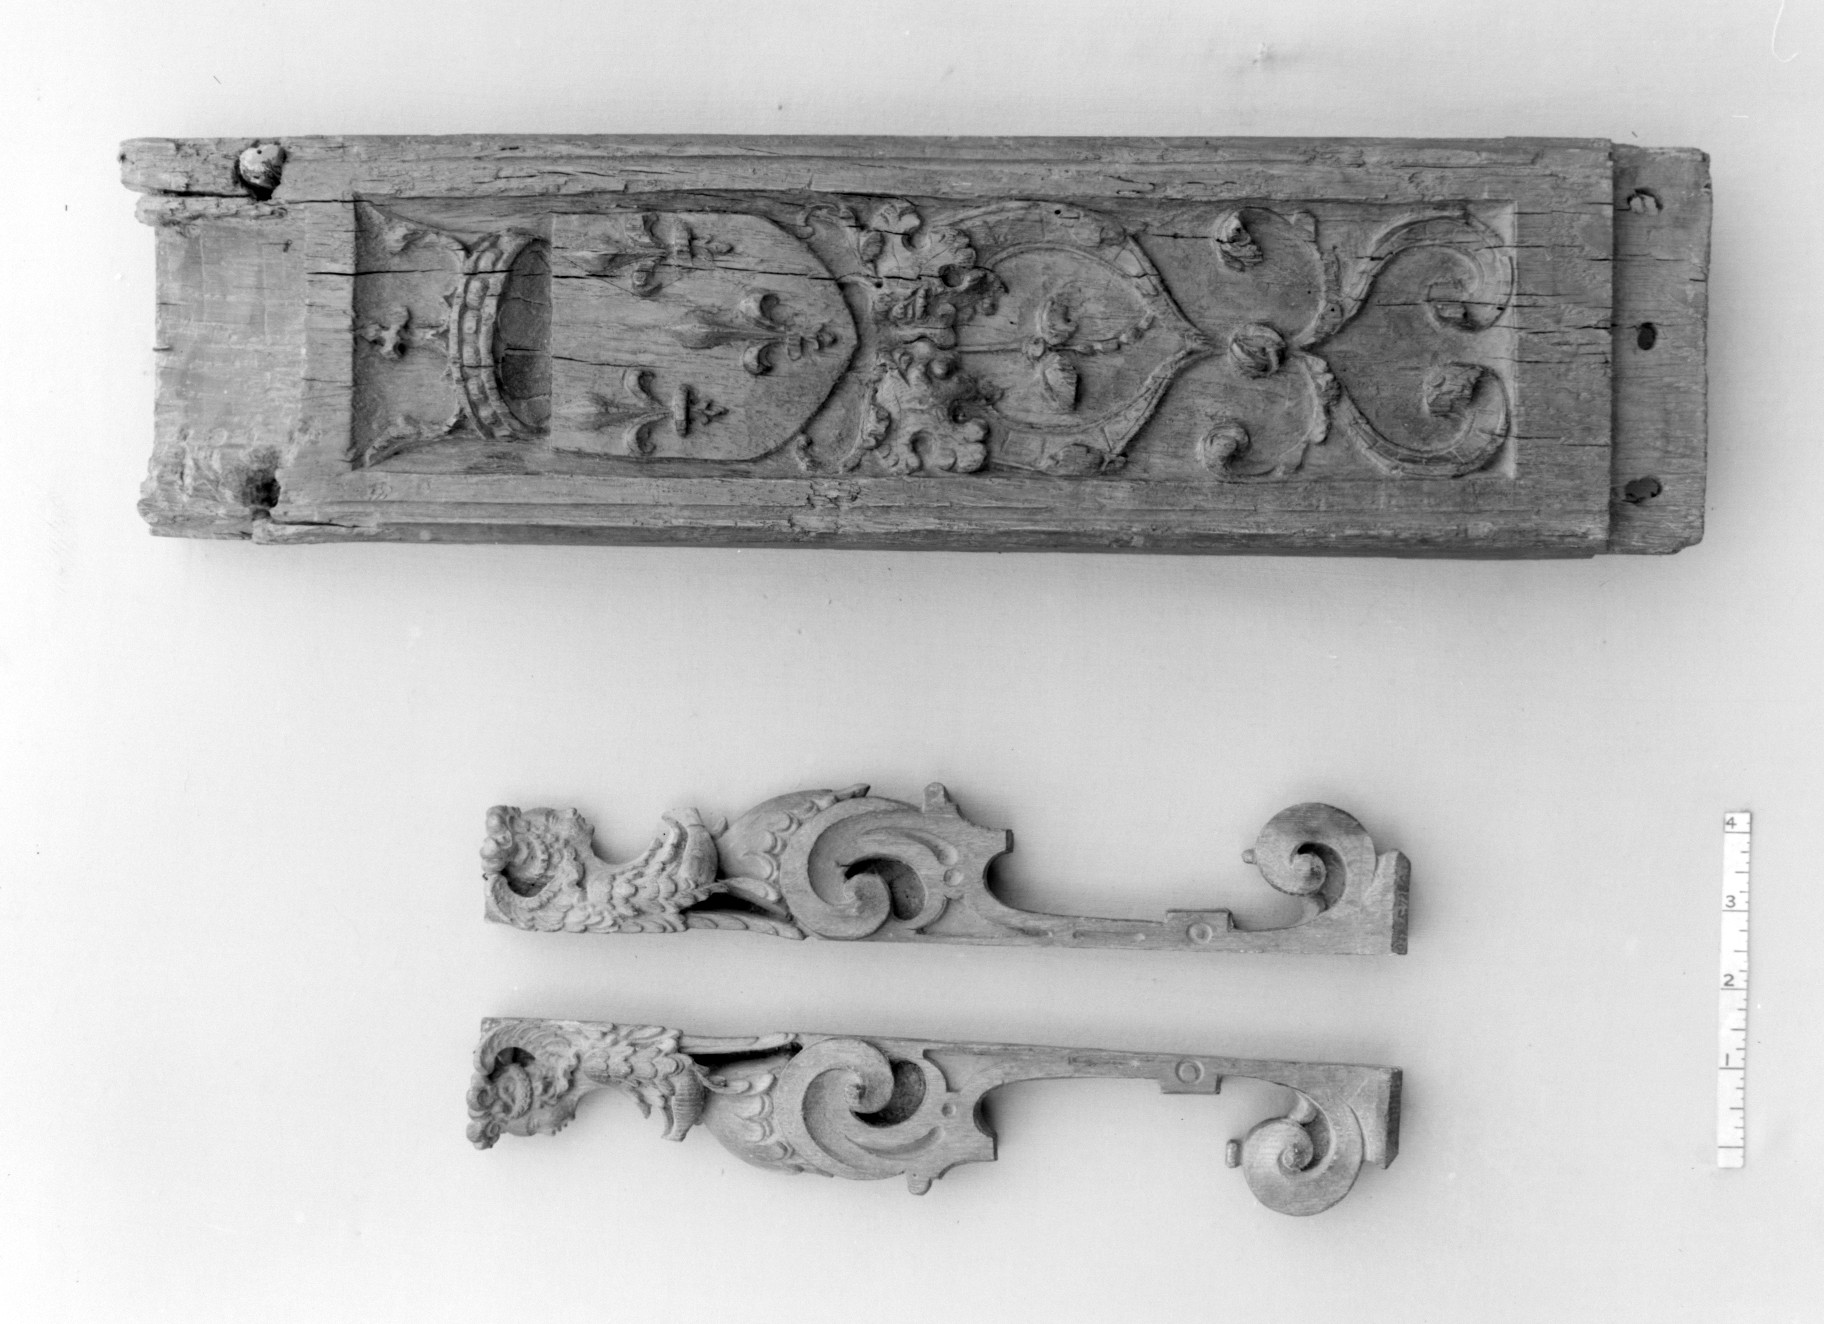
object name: panel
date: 1501-1533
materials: wood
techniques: carving